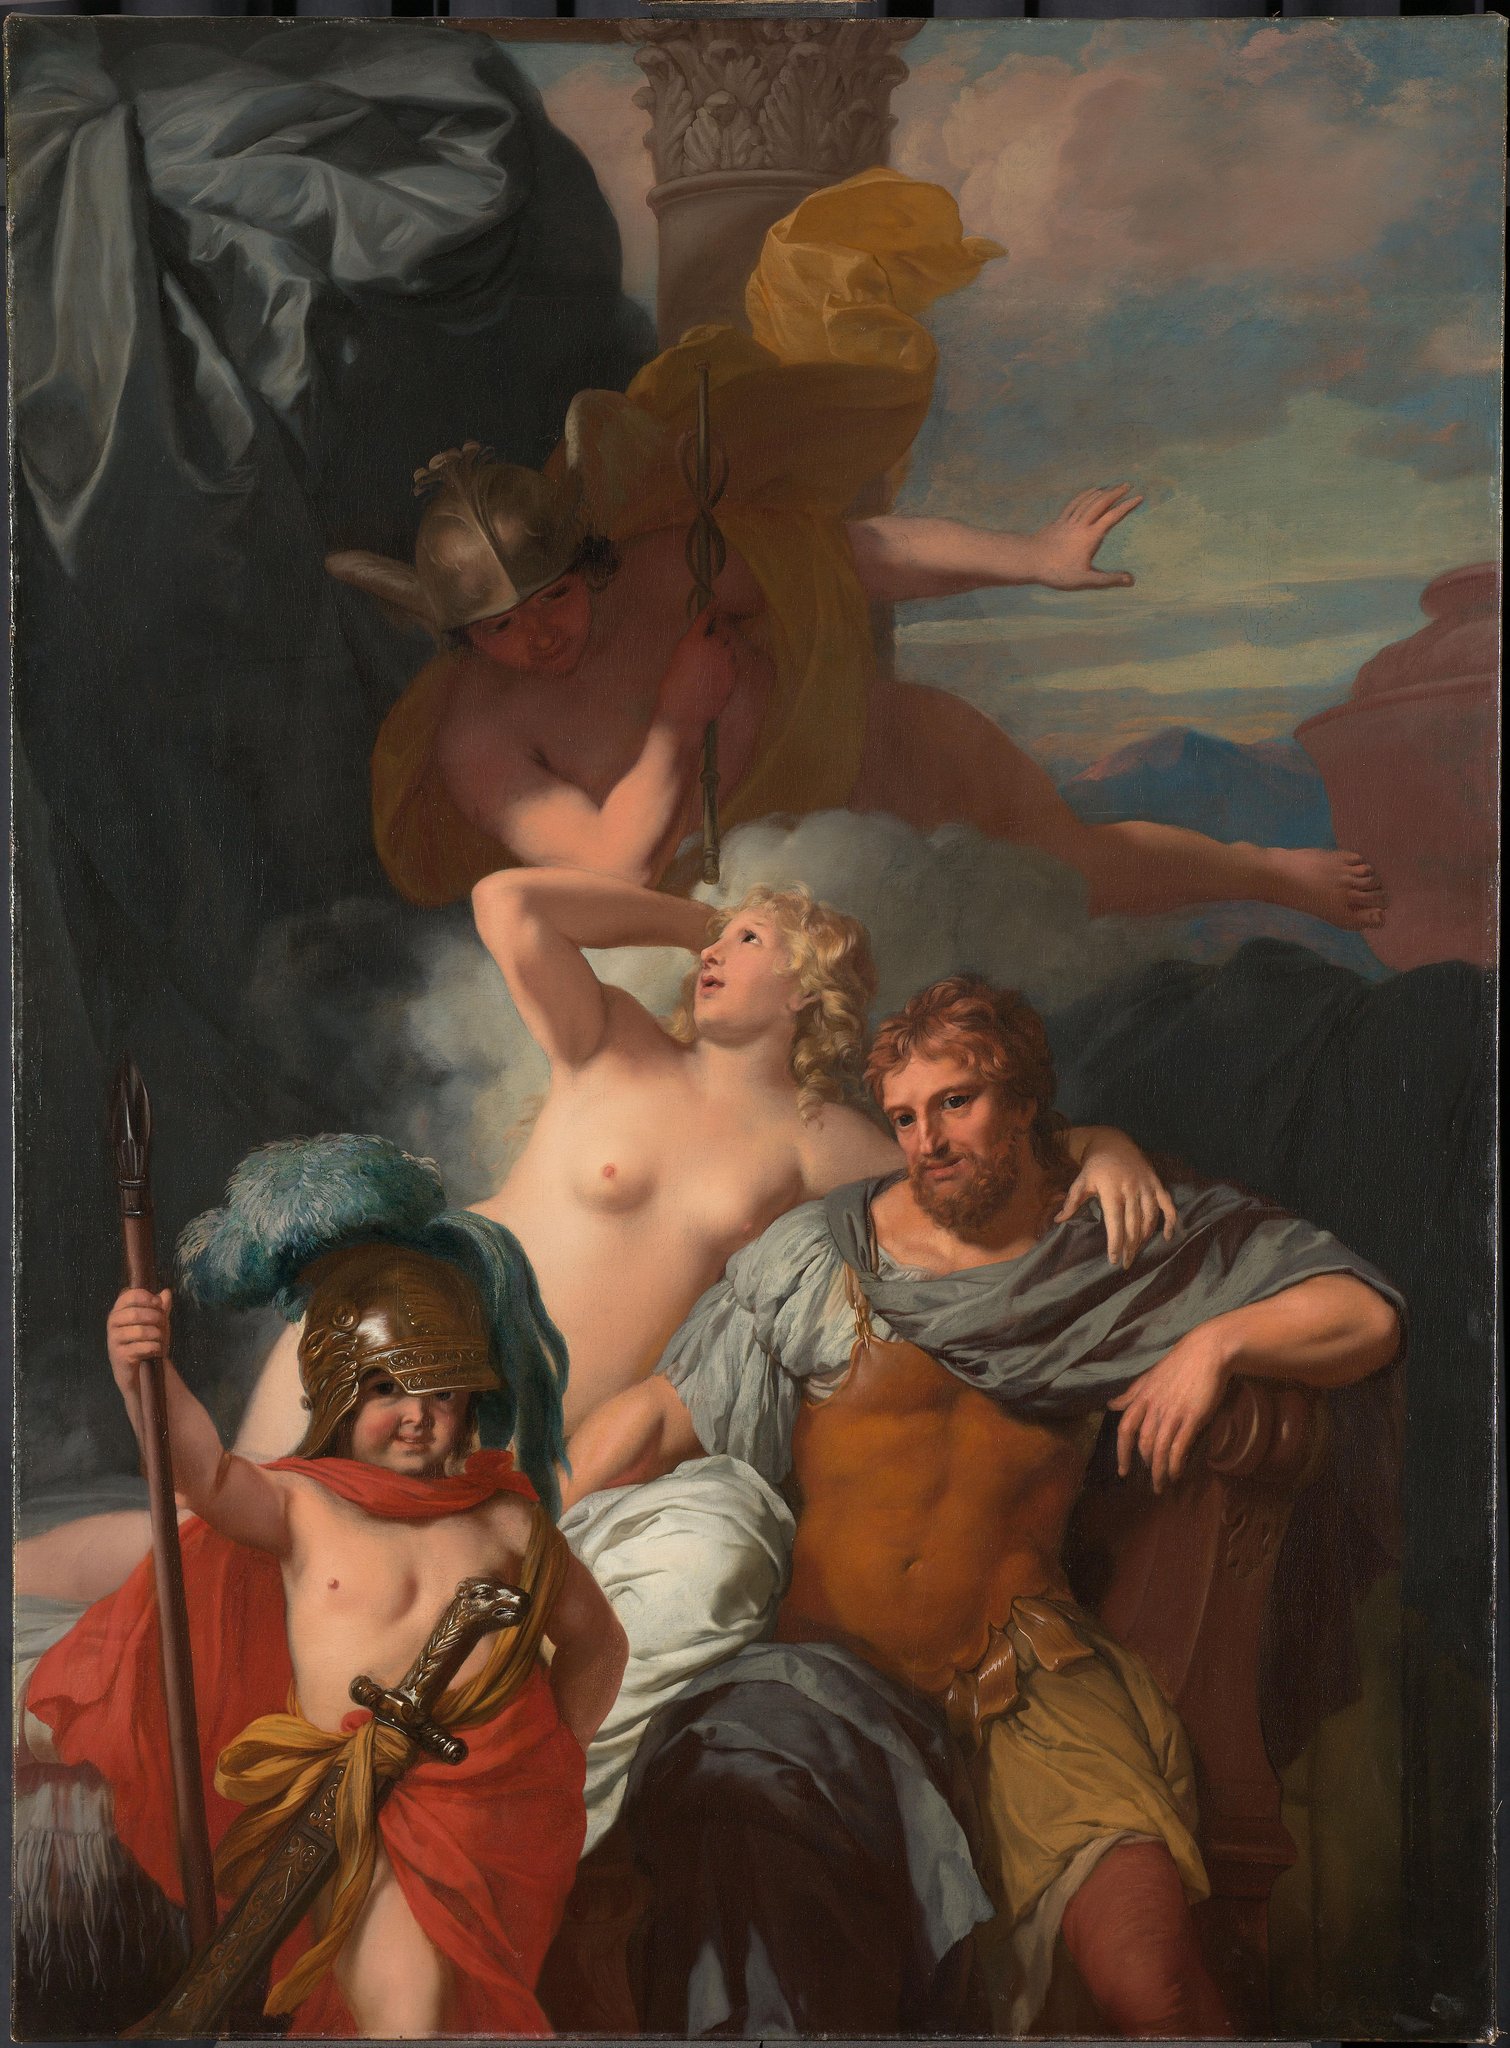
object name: painting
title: Mercury Ordering Calypso to Release Odysseus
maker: gerard de lairesse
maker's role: draughtsman, painter, print maker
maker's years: 1641-1711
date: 1680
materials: canvas, oil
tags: mercury orders calypso to release ulysses (homer, odyssey v), (story of) cupid, amor (eros)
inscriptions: signature: ‘G. Lairesse f.’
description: During his wanderings, Odysseus encounters the nymph Calypso, who falls in love with him and holds him captive on her island. Jupiter then sends Mercury to command her to let Odysseus return to his wife. Lairesse made this painting, together with several other works representing exemplary love and devotion, for Mary Stuart’s apartments in Soestdijk Palace.